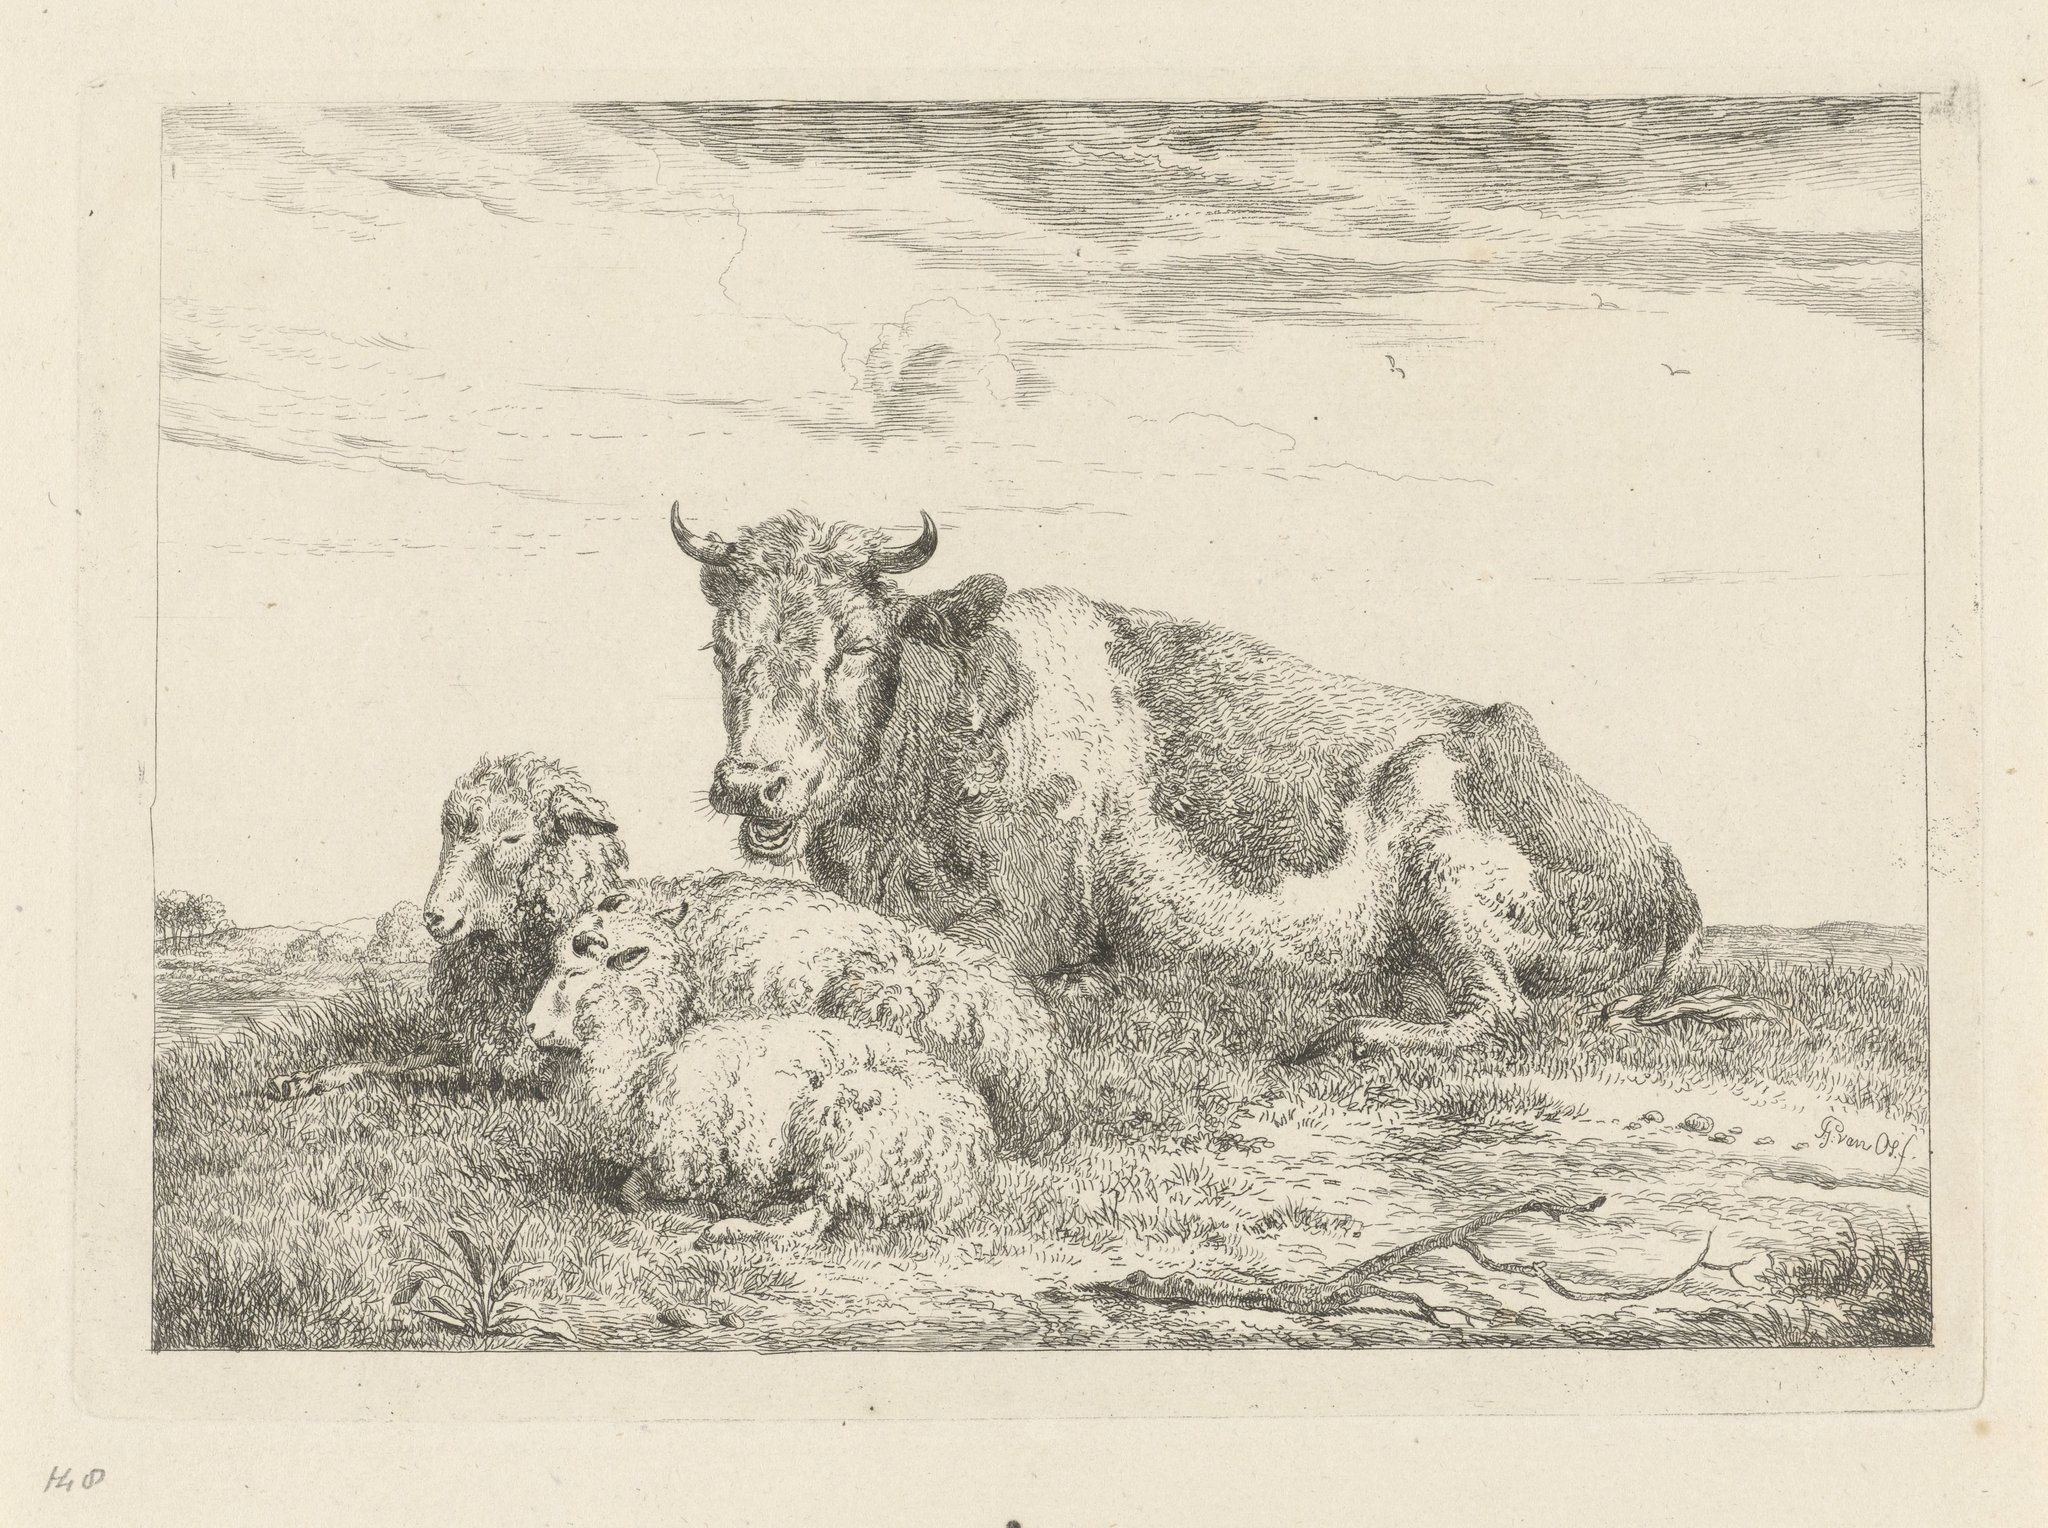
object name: print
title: Slapende koe met schaap en lammetje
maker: pieter gerardus van os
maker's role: draughtsman, painter, print maker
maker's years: 1776-1839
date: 1791-1839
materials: paper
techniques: etching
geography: netherlands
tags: cow, sheep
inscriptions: collector's mark: Lugt 2228